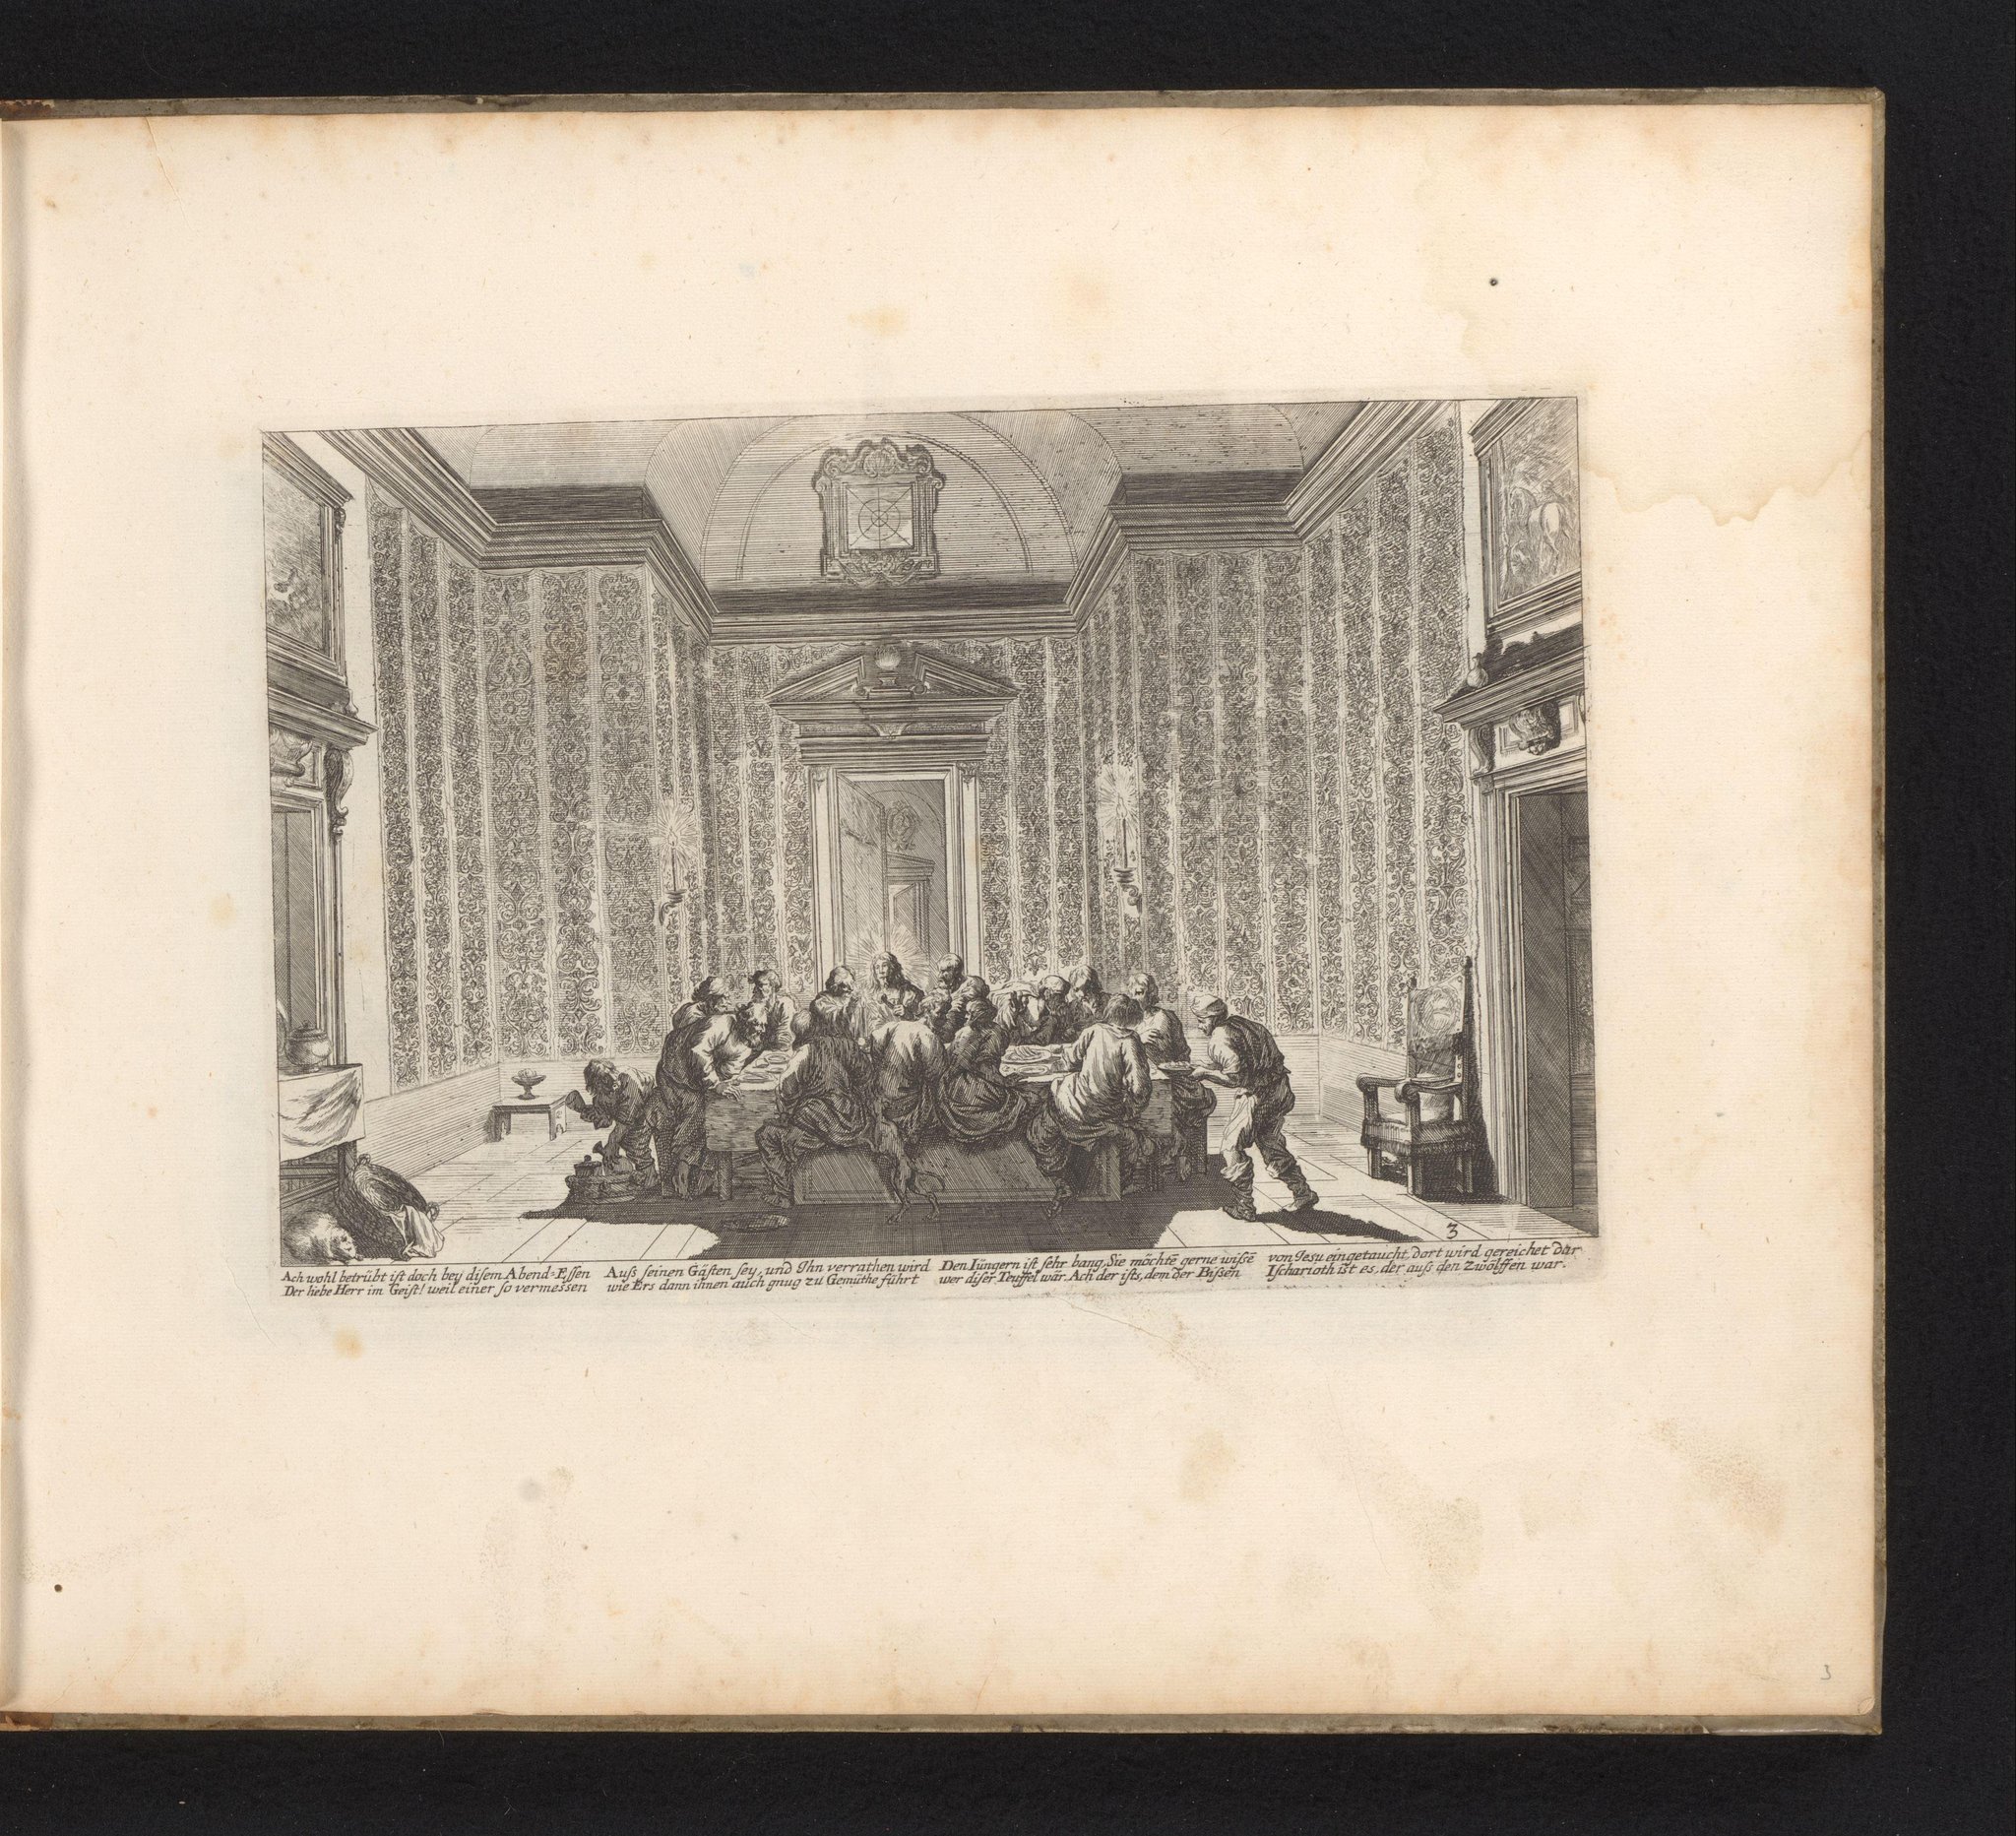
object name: album leaf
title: Het Laatste Avondmaal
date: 1670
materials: paper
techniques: etching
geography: augsburg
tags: last supper (in general) (matthew 26:21-35; mark 14:18-31; luke 22:3, 22:15-23; john 13:21-38)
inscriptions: collector's mark: Lugt 2228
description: Tekst in het Duits in de ondermarge. Rechtsonder genummerd: 3. Prent maakt deel uit van een album.